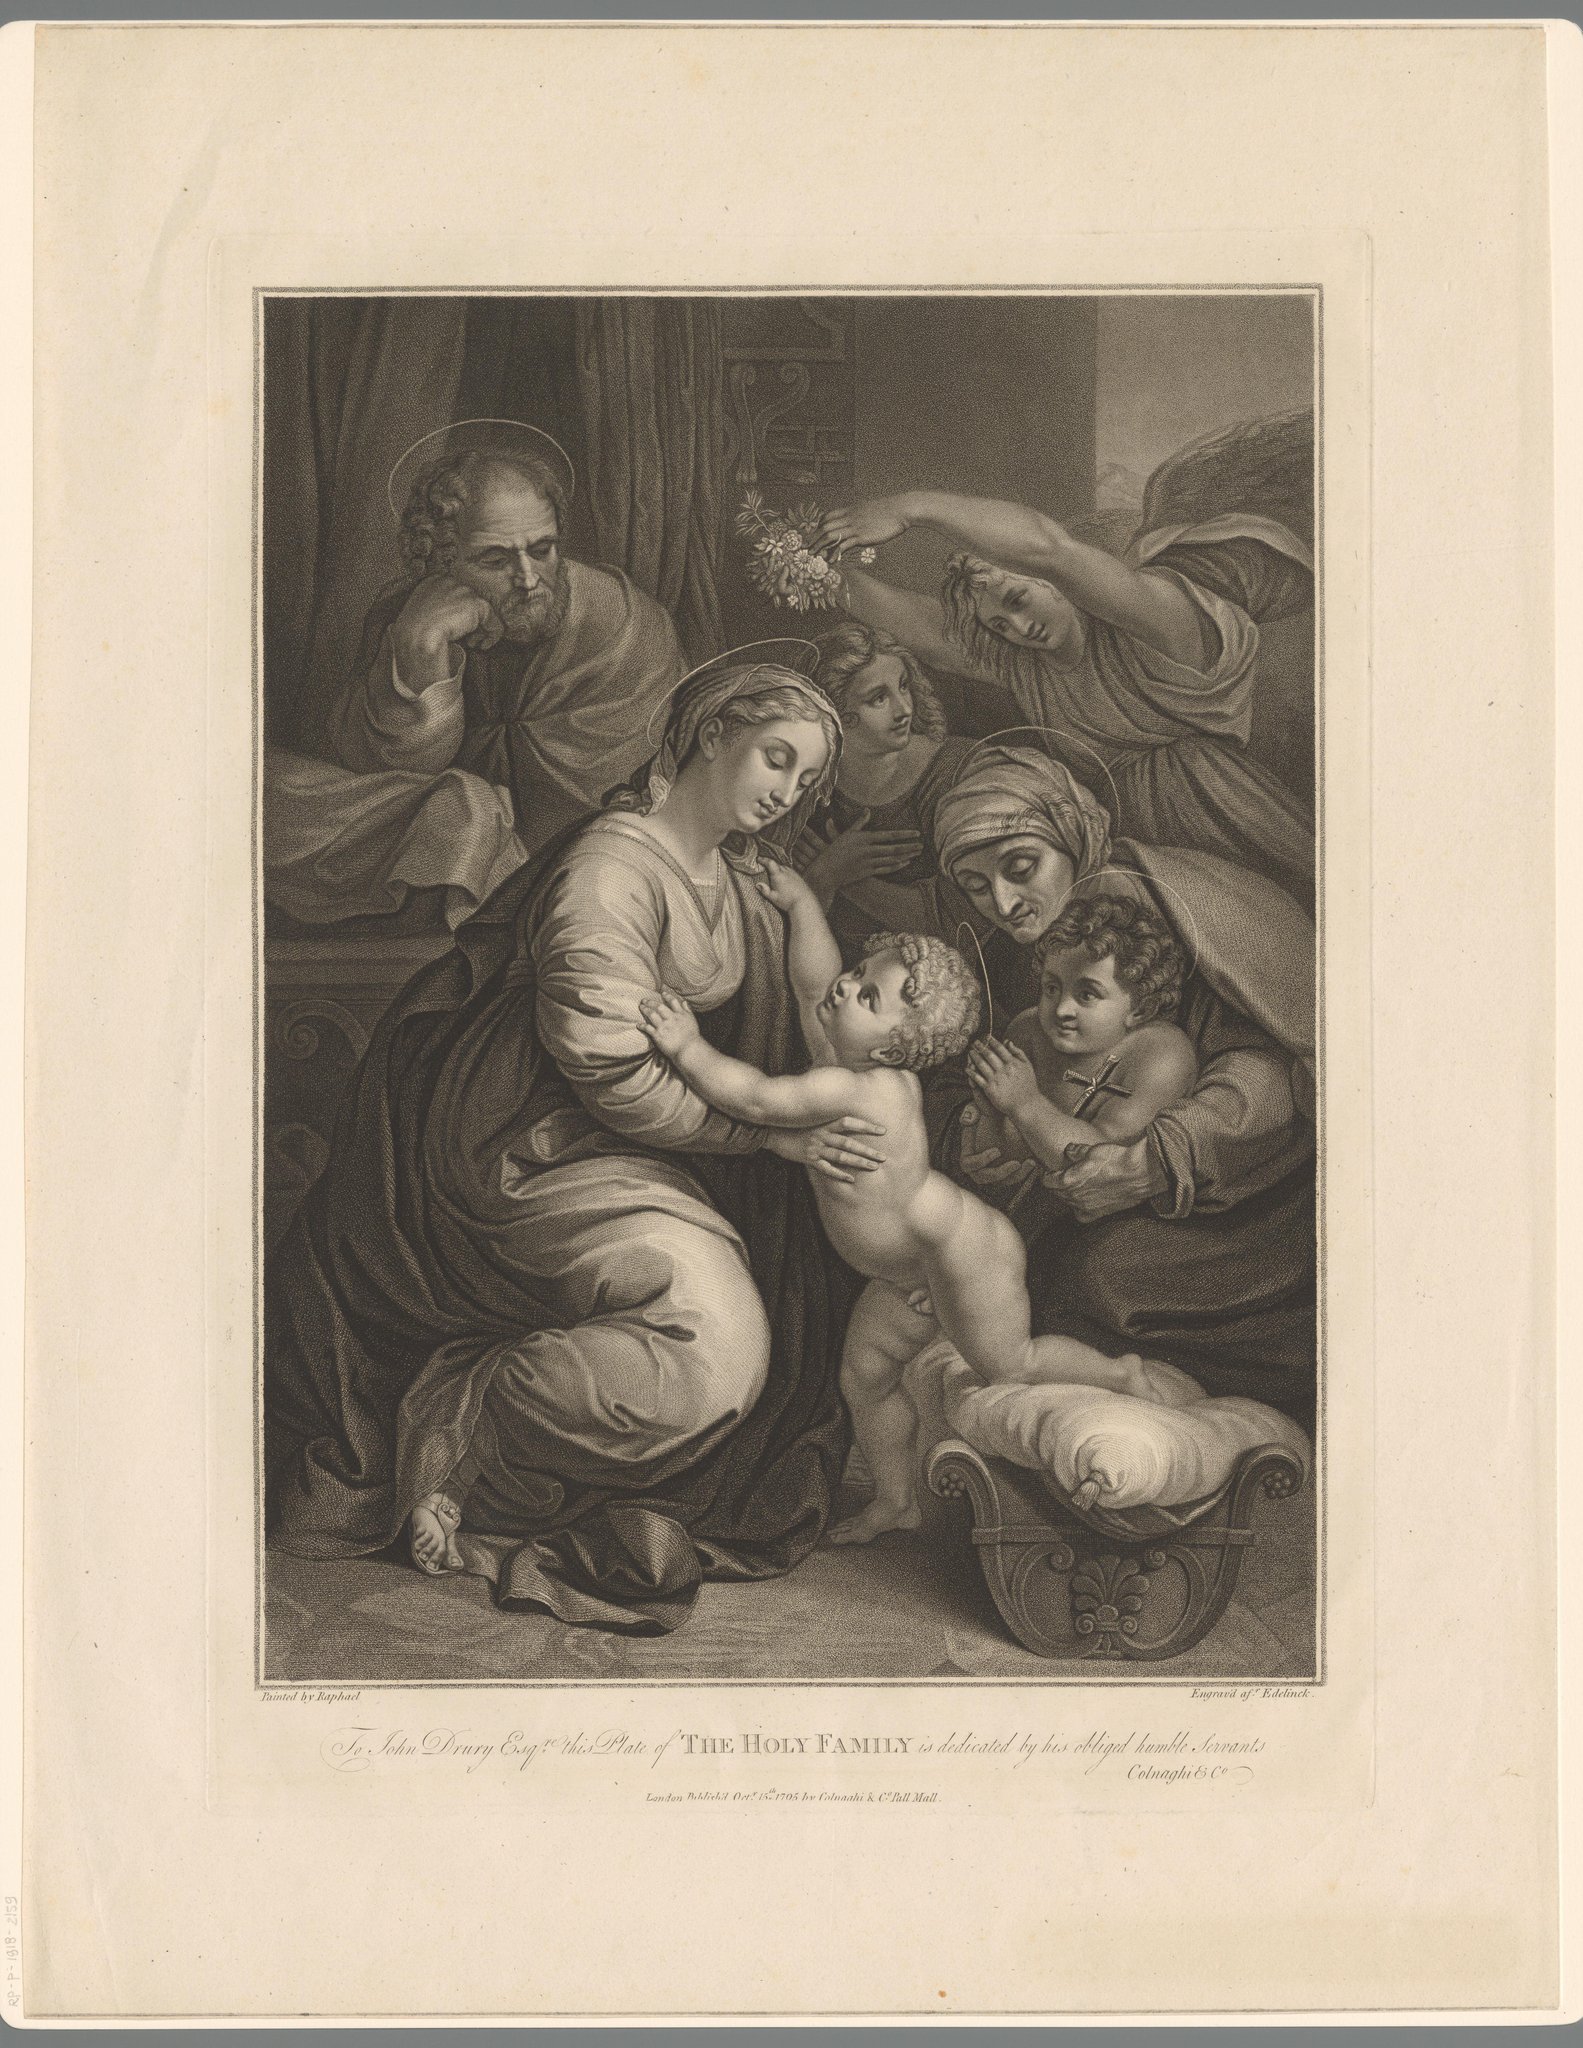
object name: print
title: Heilige Familie met Johannes de Doper en Elisabeth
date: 1705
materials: paper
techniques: etching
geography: london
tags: holy family with john the baptist, elisabeth present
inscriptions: collector's mark: Lugt 2233